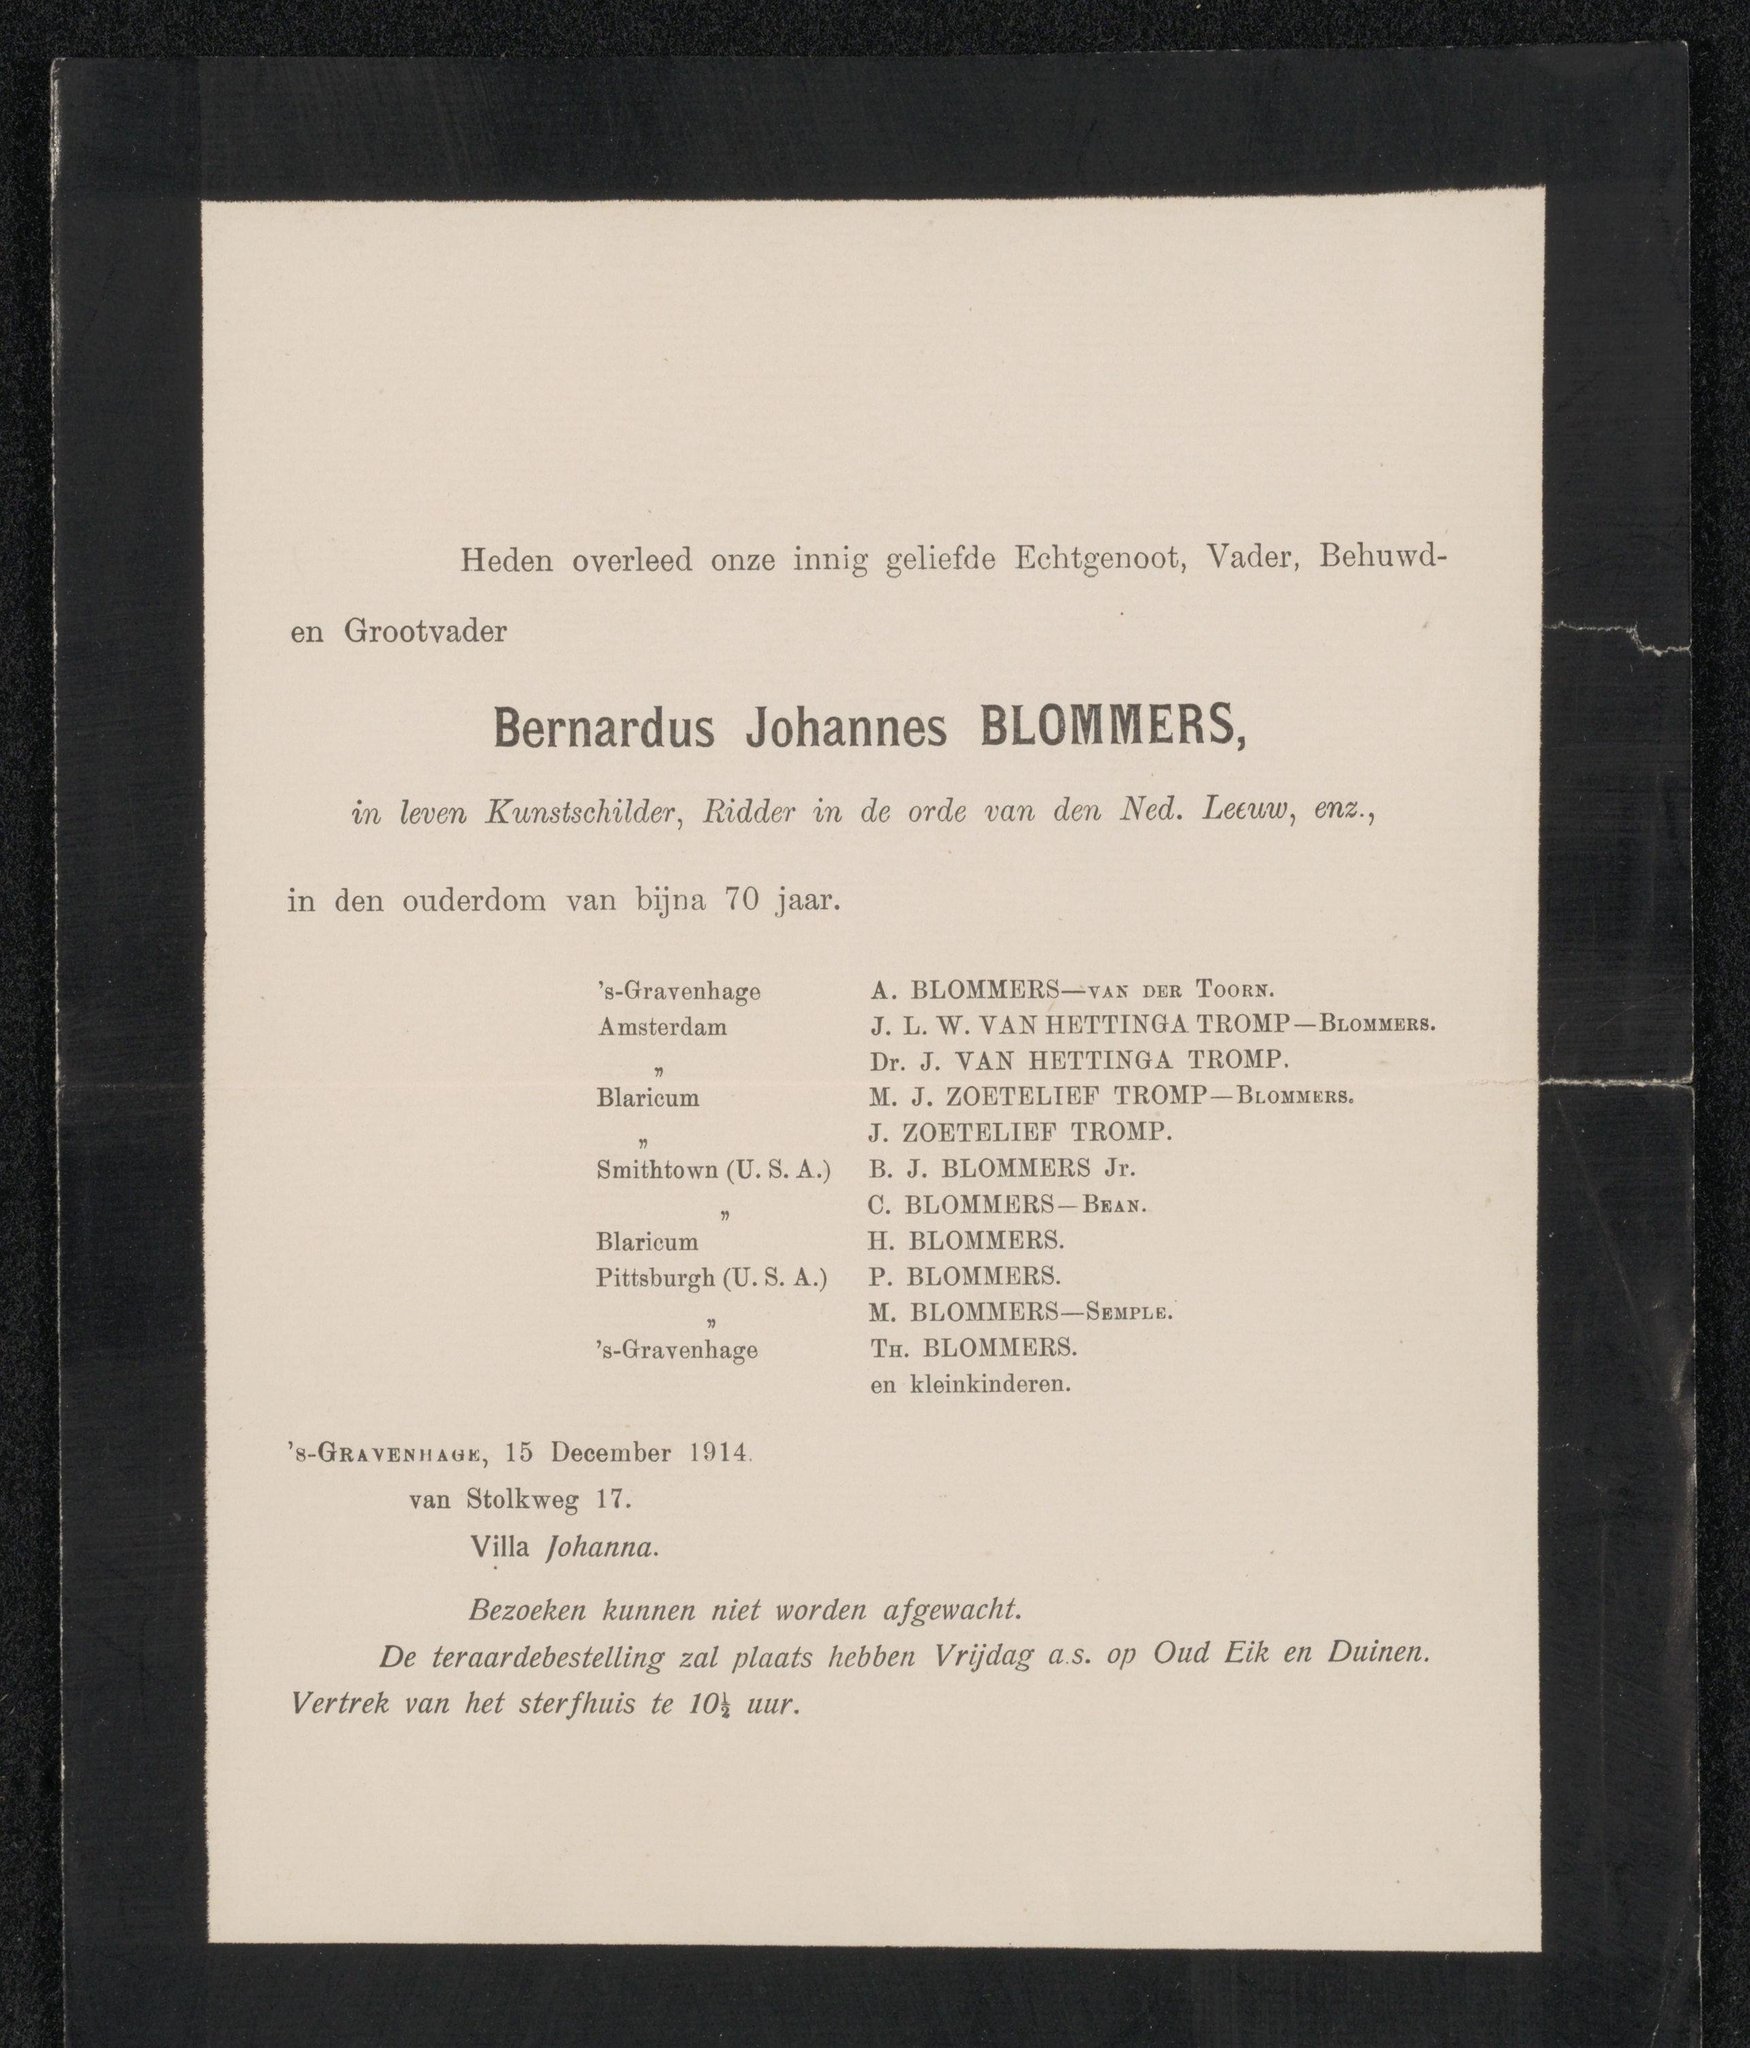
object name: overlijdensbericht, overlijdensadvertentie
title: Overlijdensbericht van Bernardus Johannes Blommers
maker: Anonymous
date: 1914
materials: paper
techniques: printing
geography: the hague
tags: the hague, draughtsman, bernardus johannes blommers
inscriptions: collector's mark: ‘RPK’